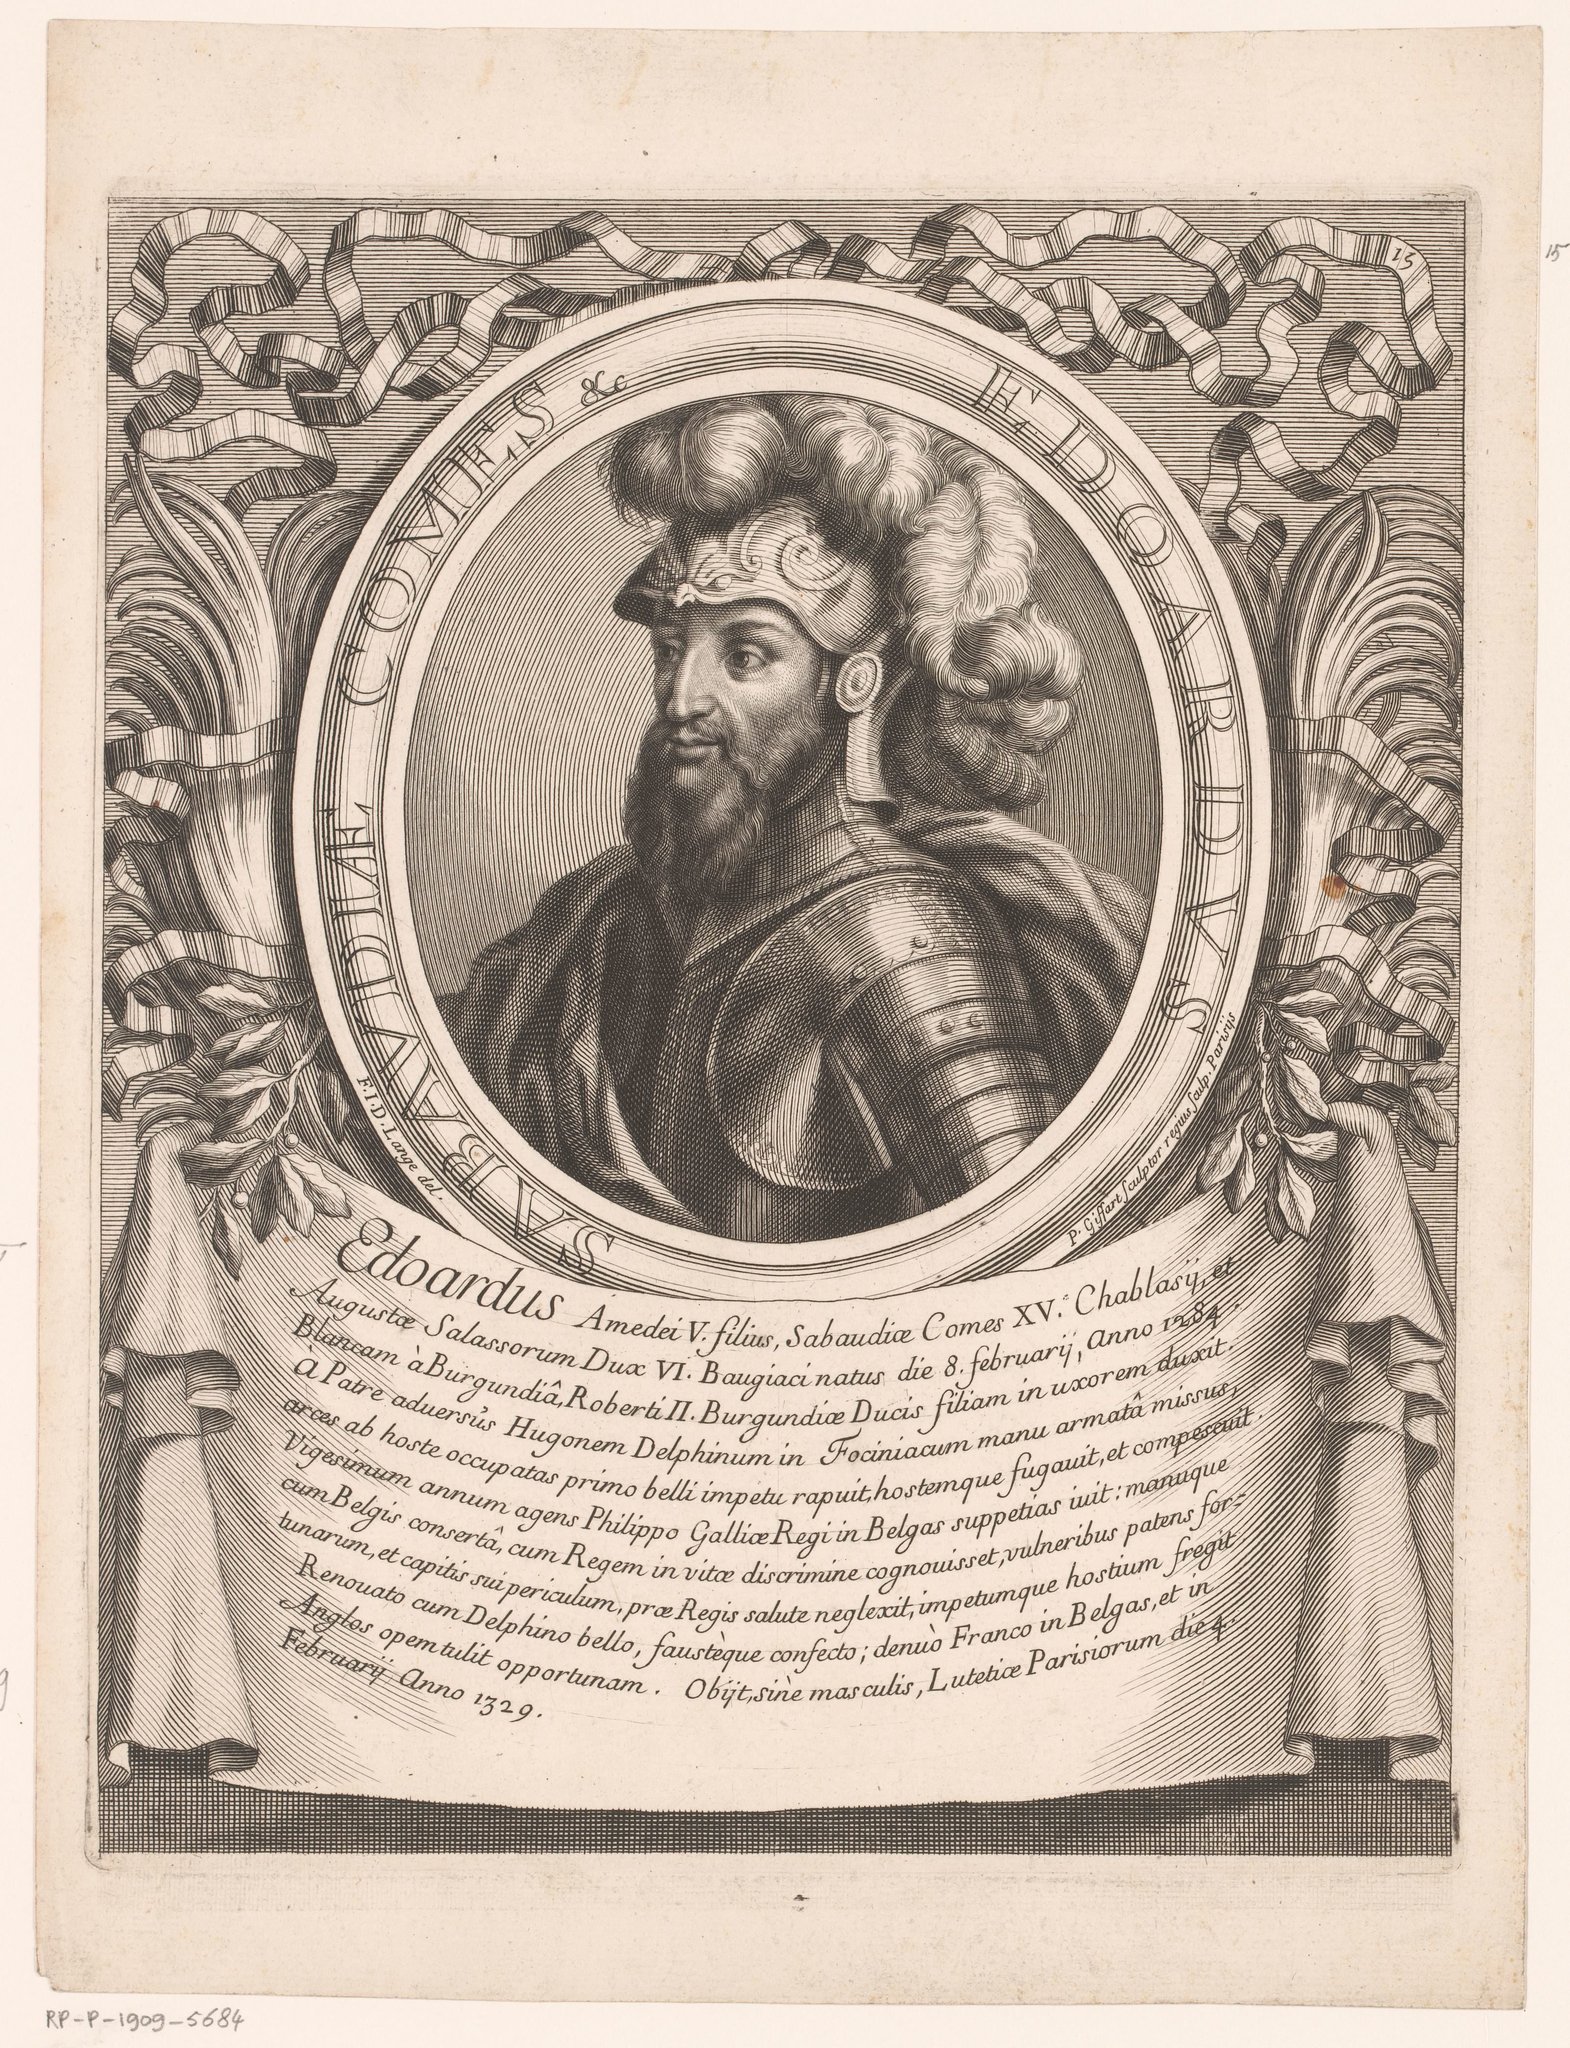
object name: print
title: Augustae regiaeque Sabaudae domus Arbor gentilitia regiae celsitudini Victori Amedeo II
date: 1702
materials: paper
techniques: engraving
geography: paris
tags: earl, historical persons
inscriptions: collector's mark: Lugt 2228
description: Maakt deel uit van een serie getiteld 'Augustae regiaeque Sabaudae domus Arbor gentilitia regiae celsitudini Victori Amedeo II' met portretten door Giffart en Tasnière van leden van het Huis van Savoye, uitgegeven in 1702 door Francesco Maria Ferrero di Lavriano.